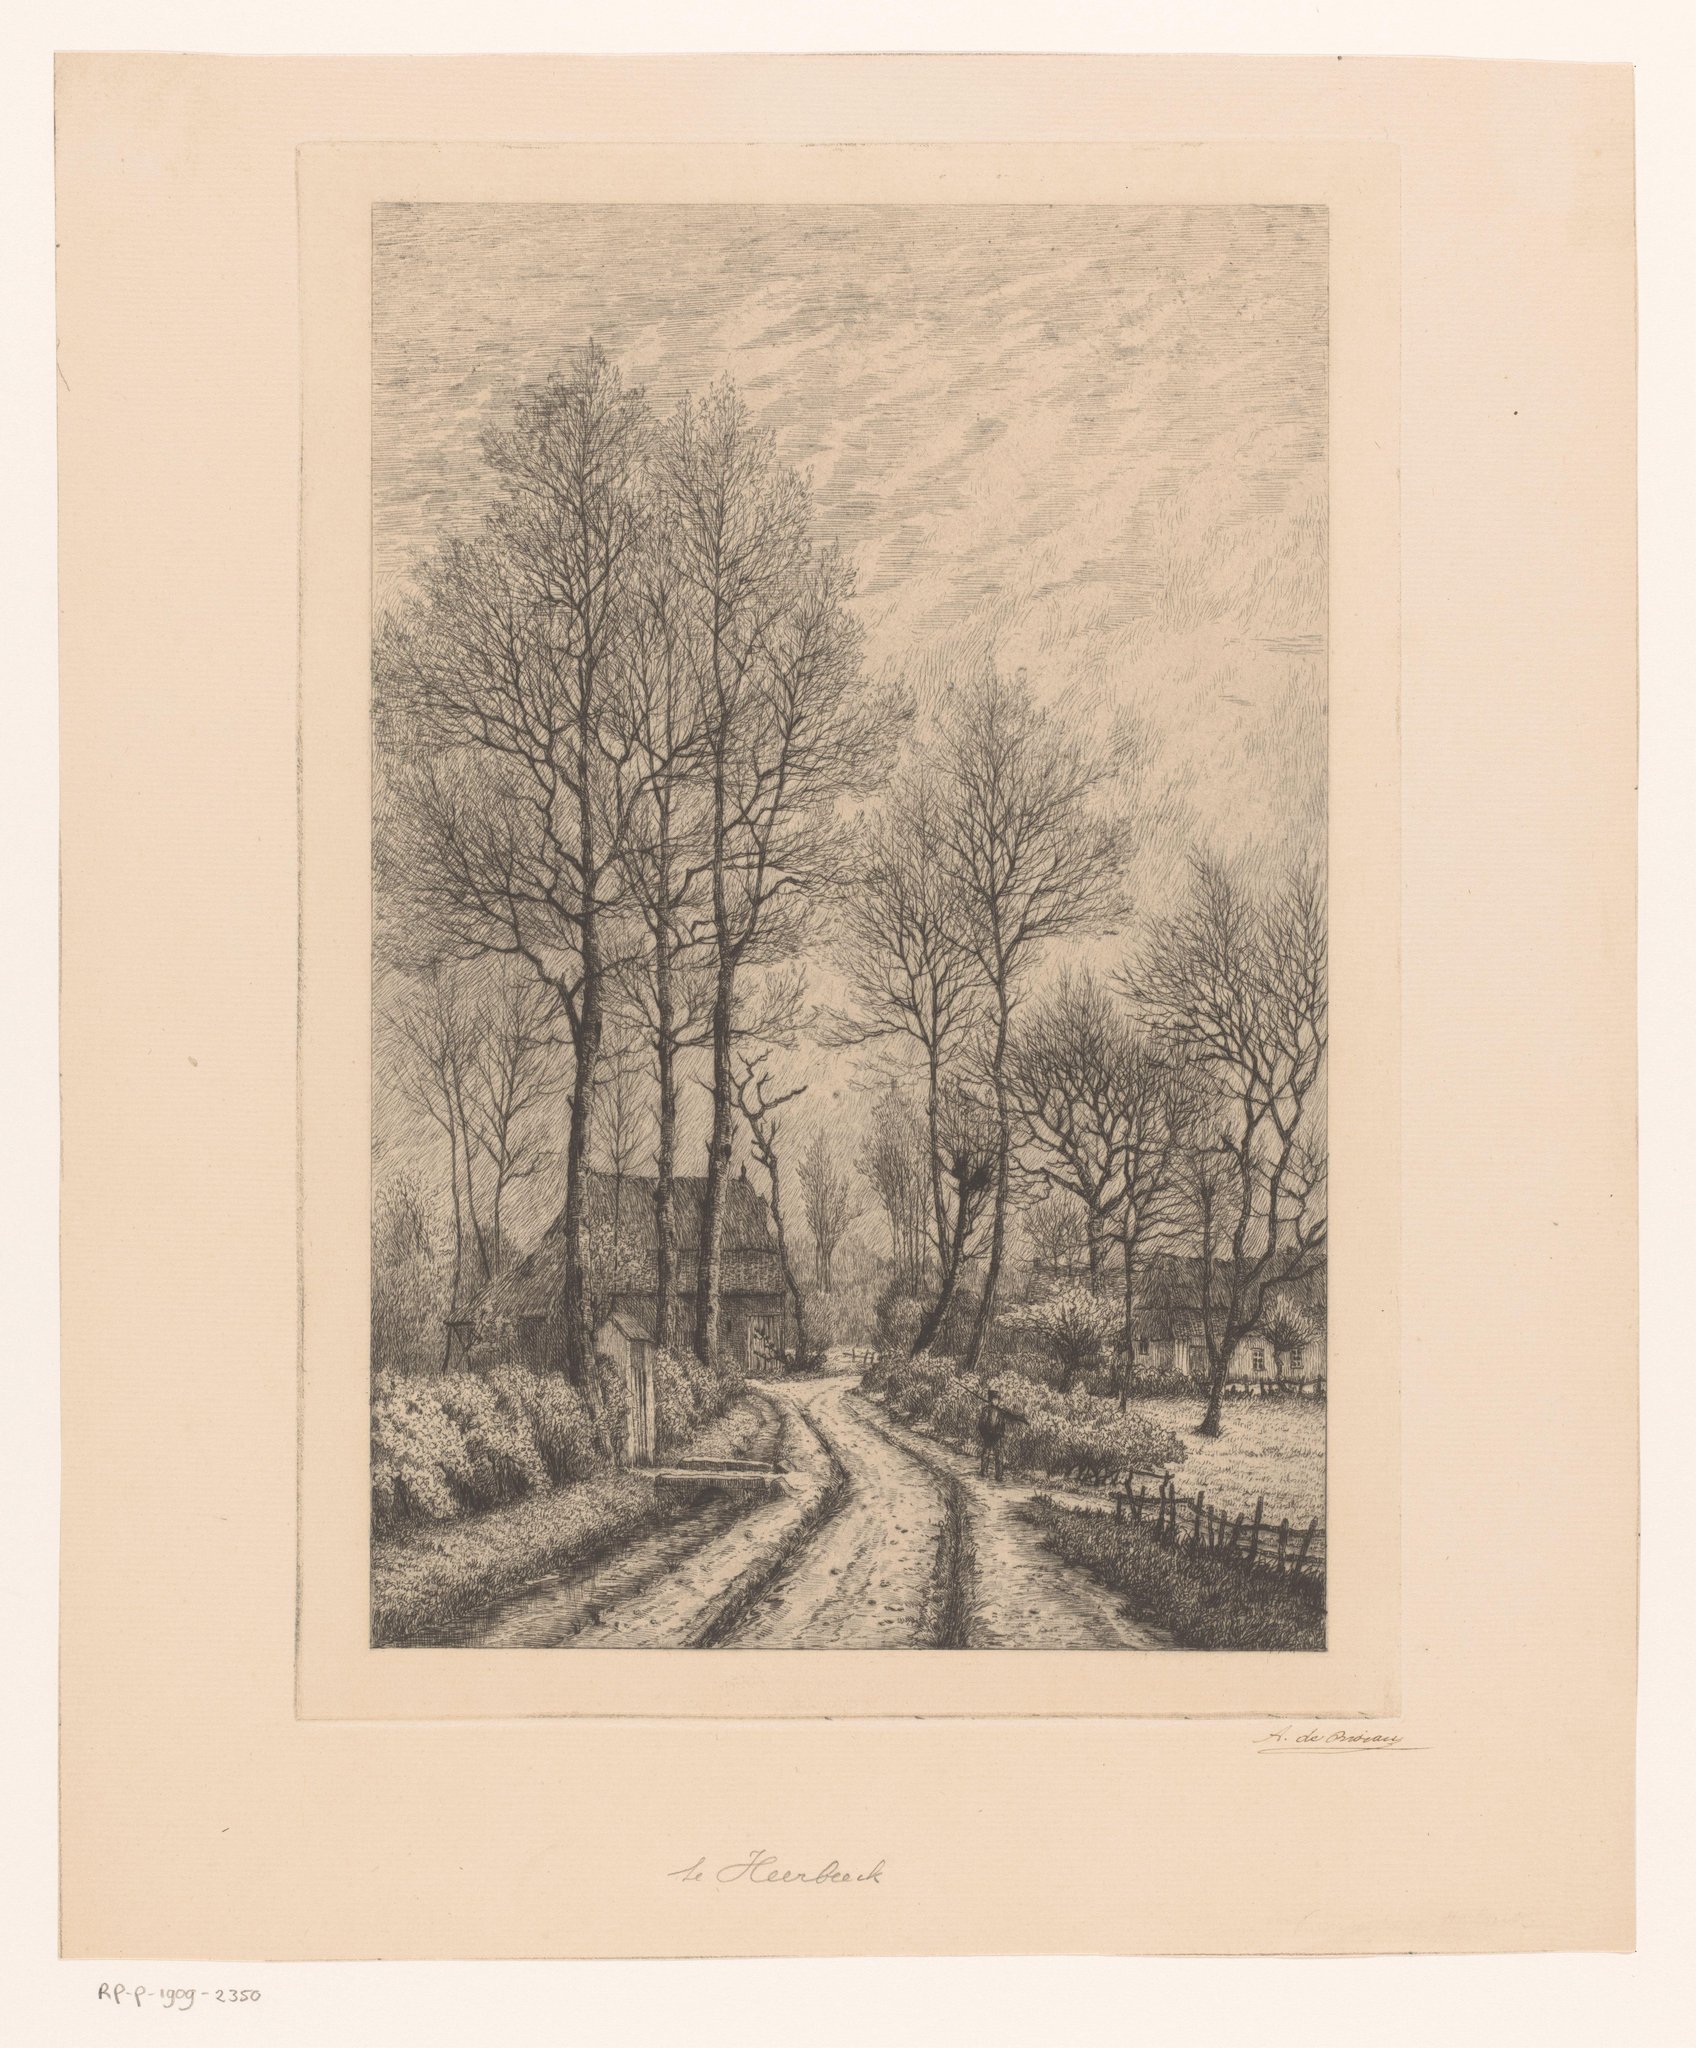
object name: print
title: Landweg met enkele hoge, kale bomen en boerenwoningen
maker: aristide de biseau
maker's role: print maker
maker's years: 1844-1883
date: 1854-1883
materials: paper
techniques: drypoint, etching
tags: landscapes, road, path, farm or solitary house in landscape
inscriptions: collector's mark: Lugt 2228